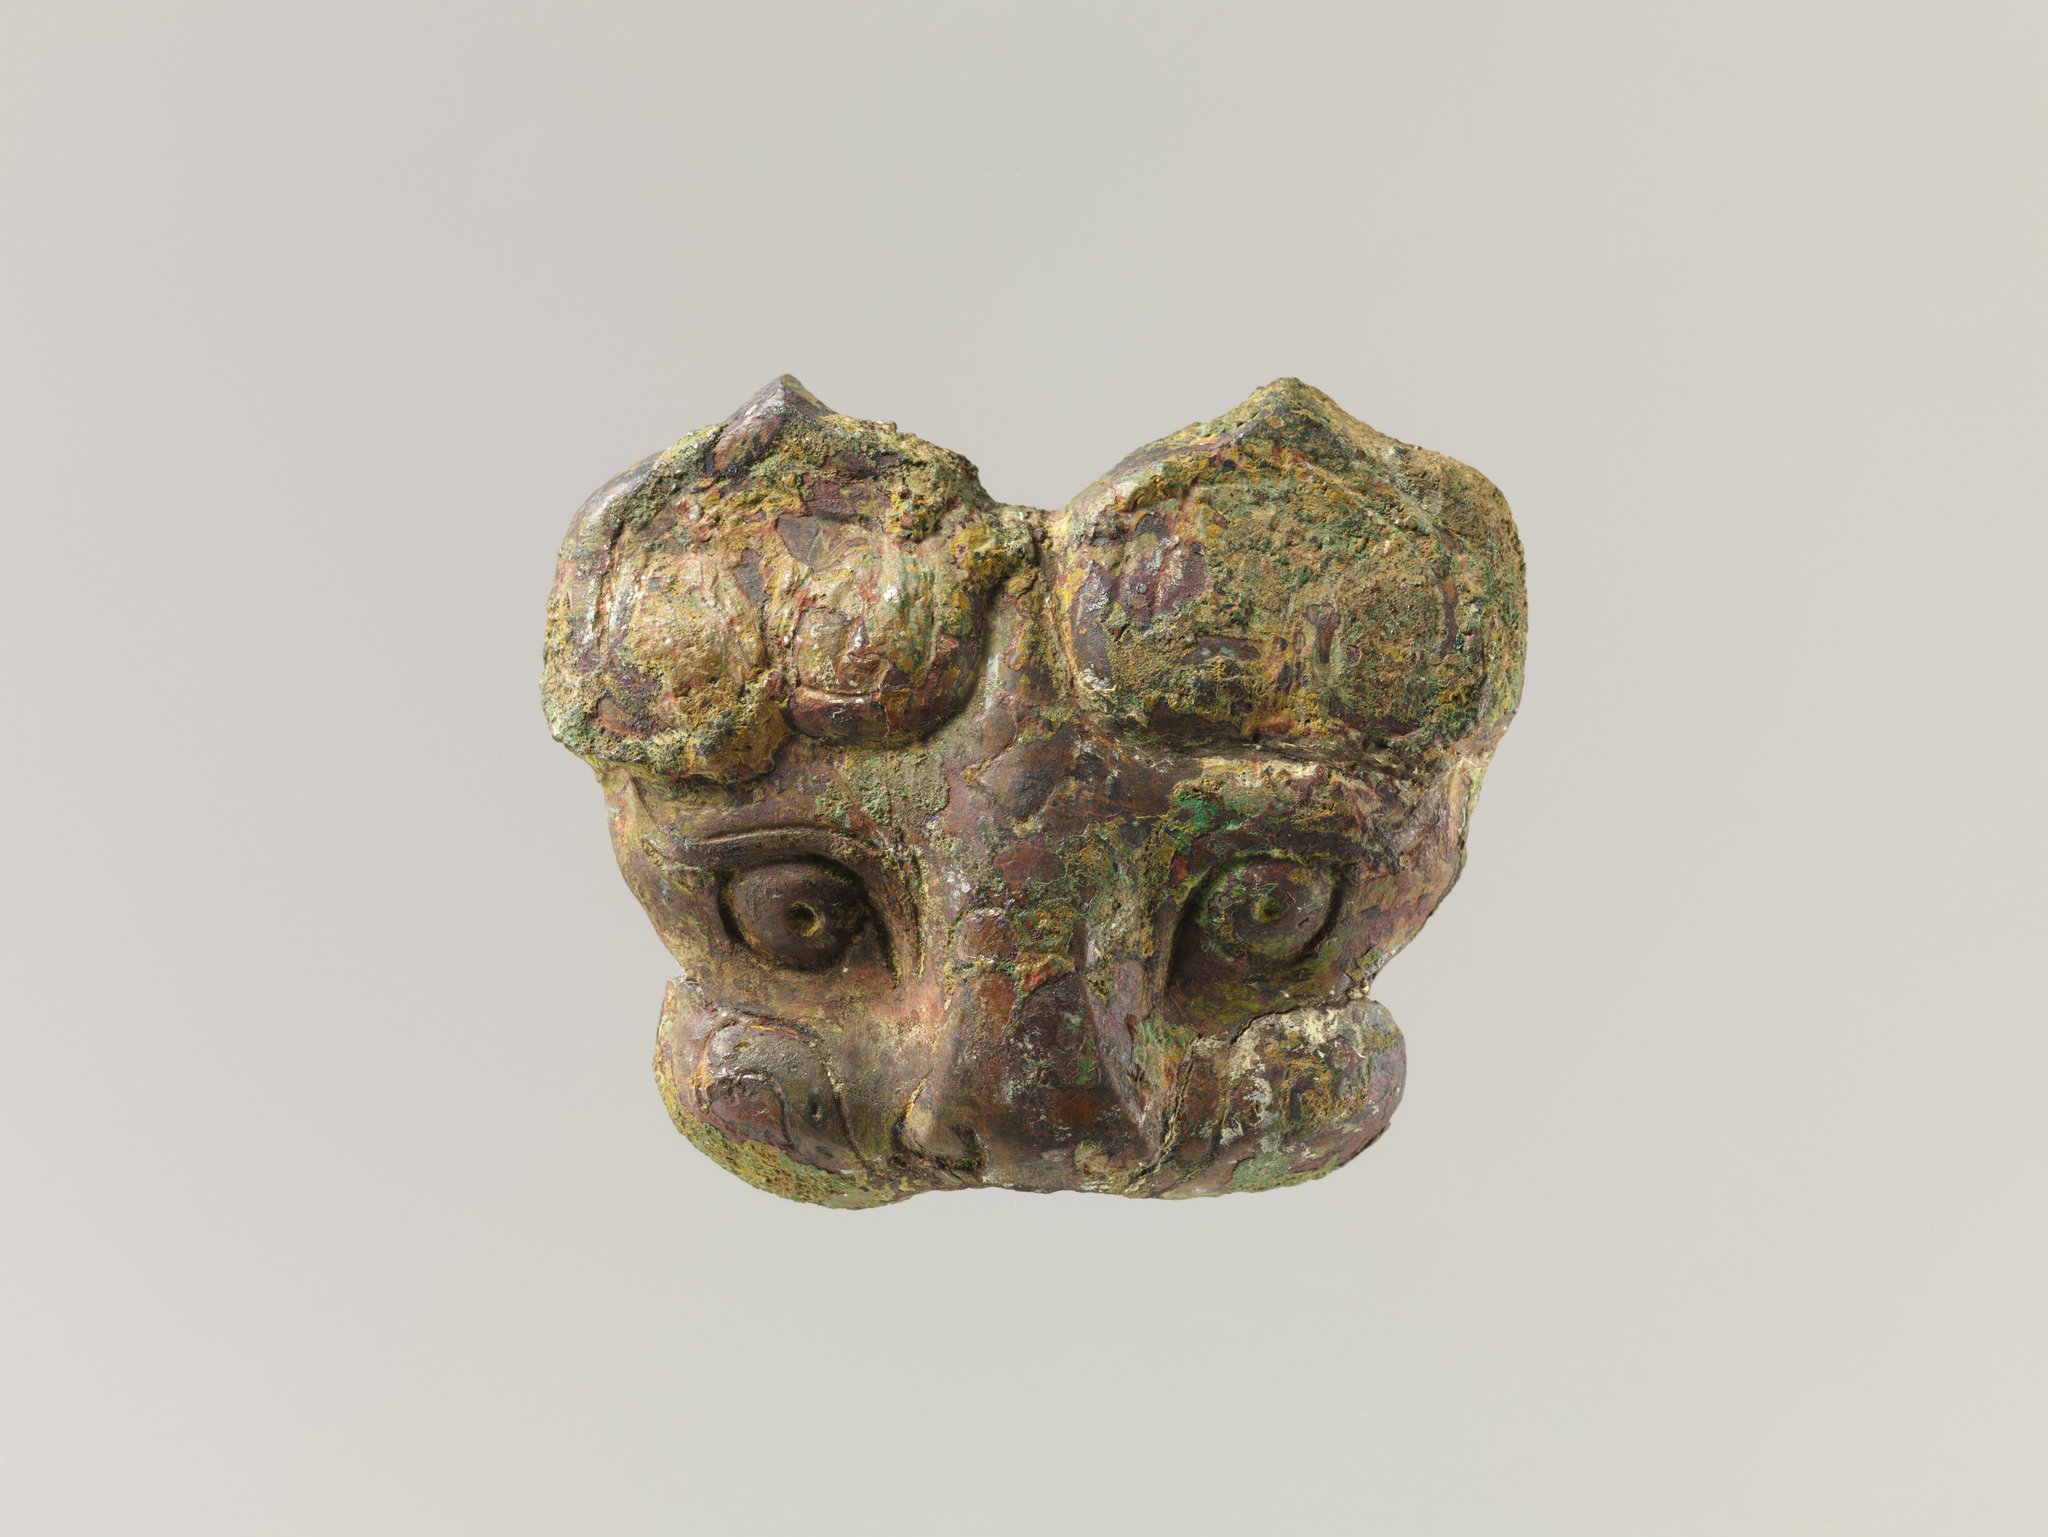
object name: fitting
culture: chinese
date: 1000-901 BCE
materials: bronze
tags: masks,lions